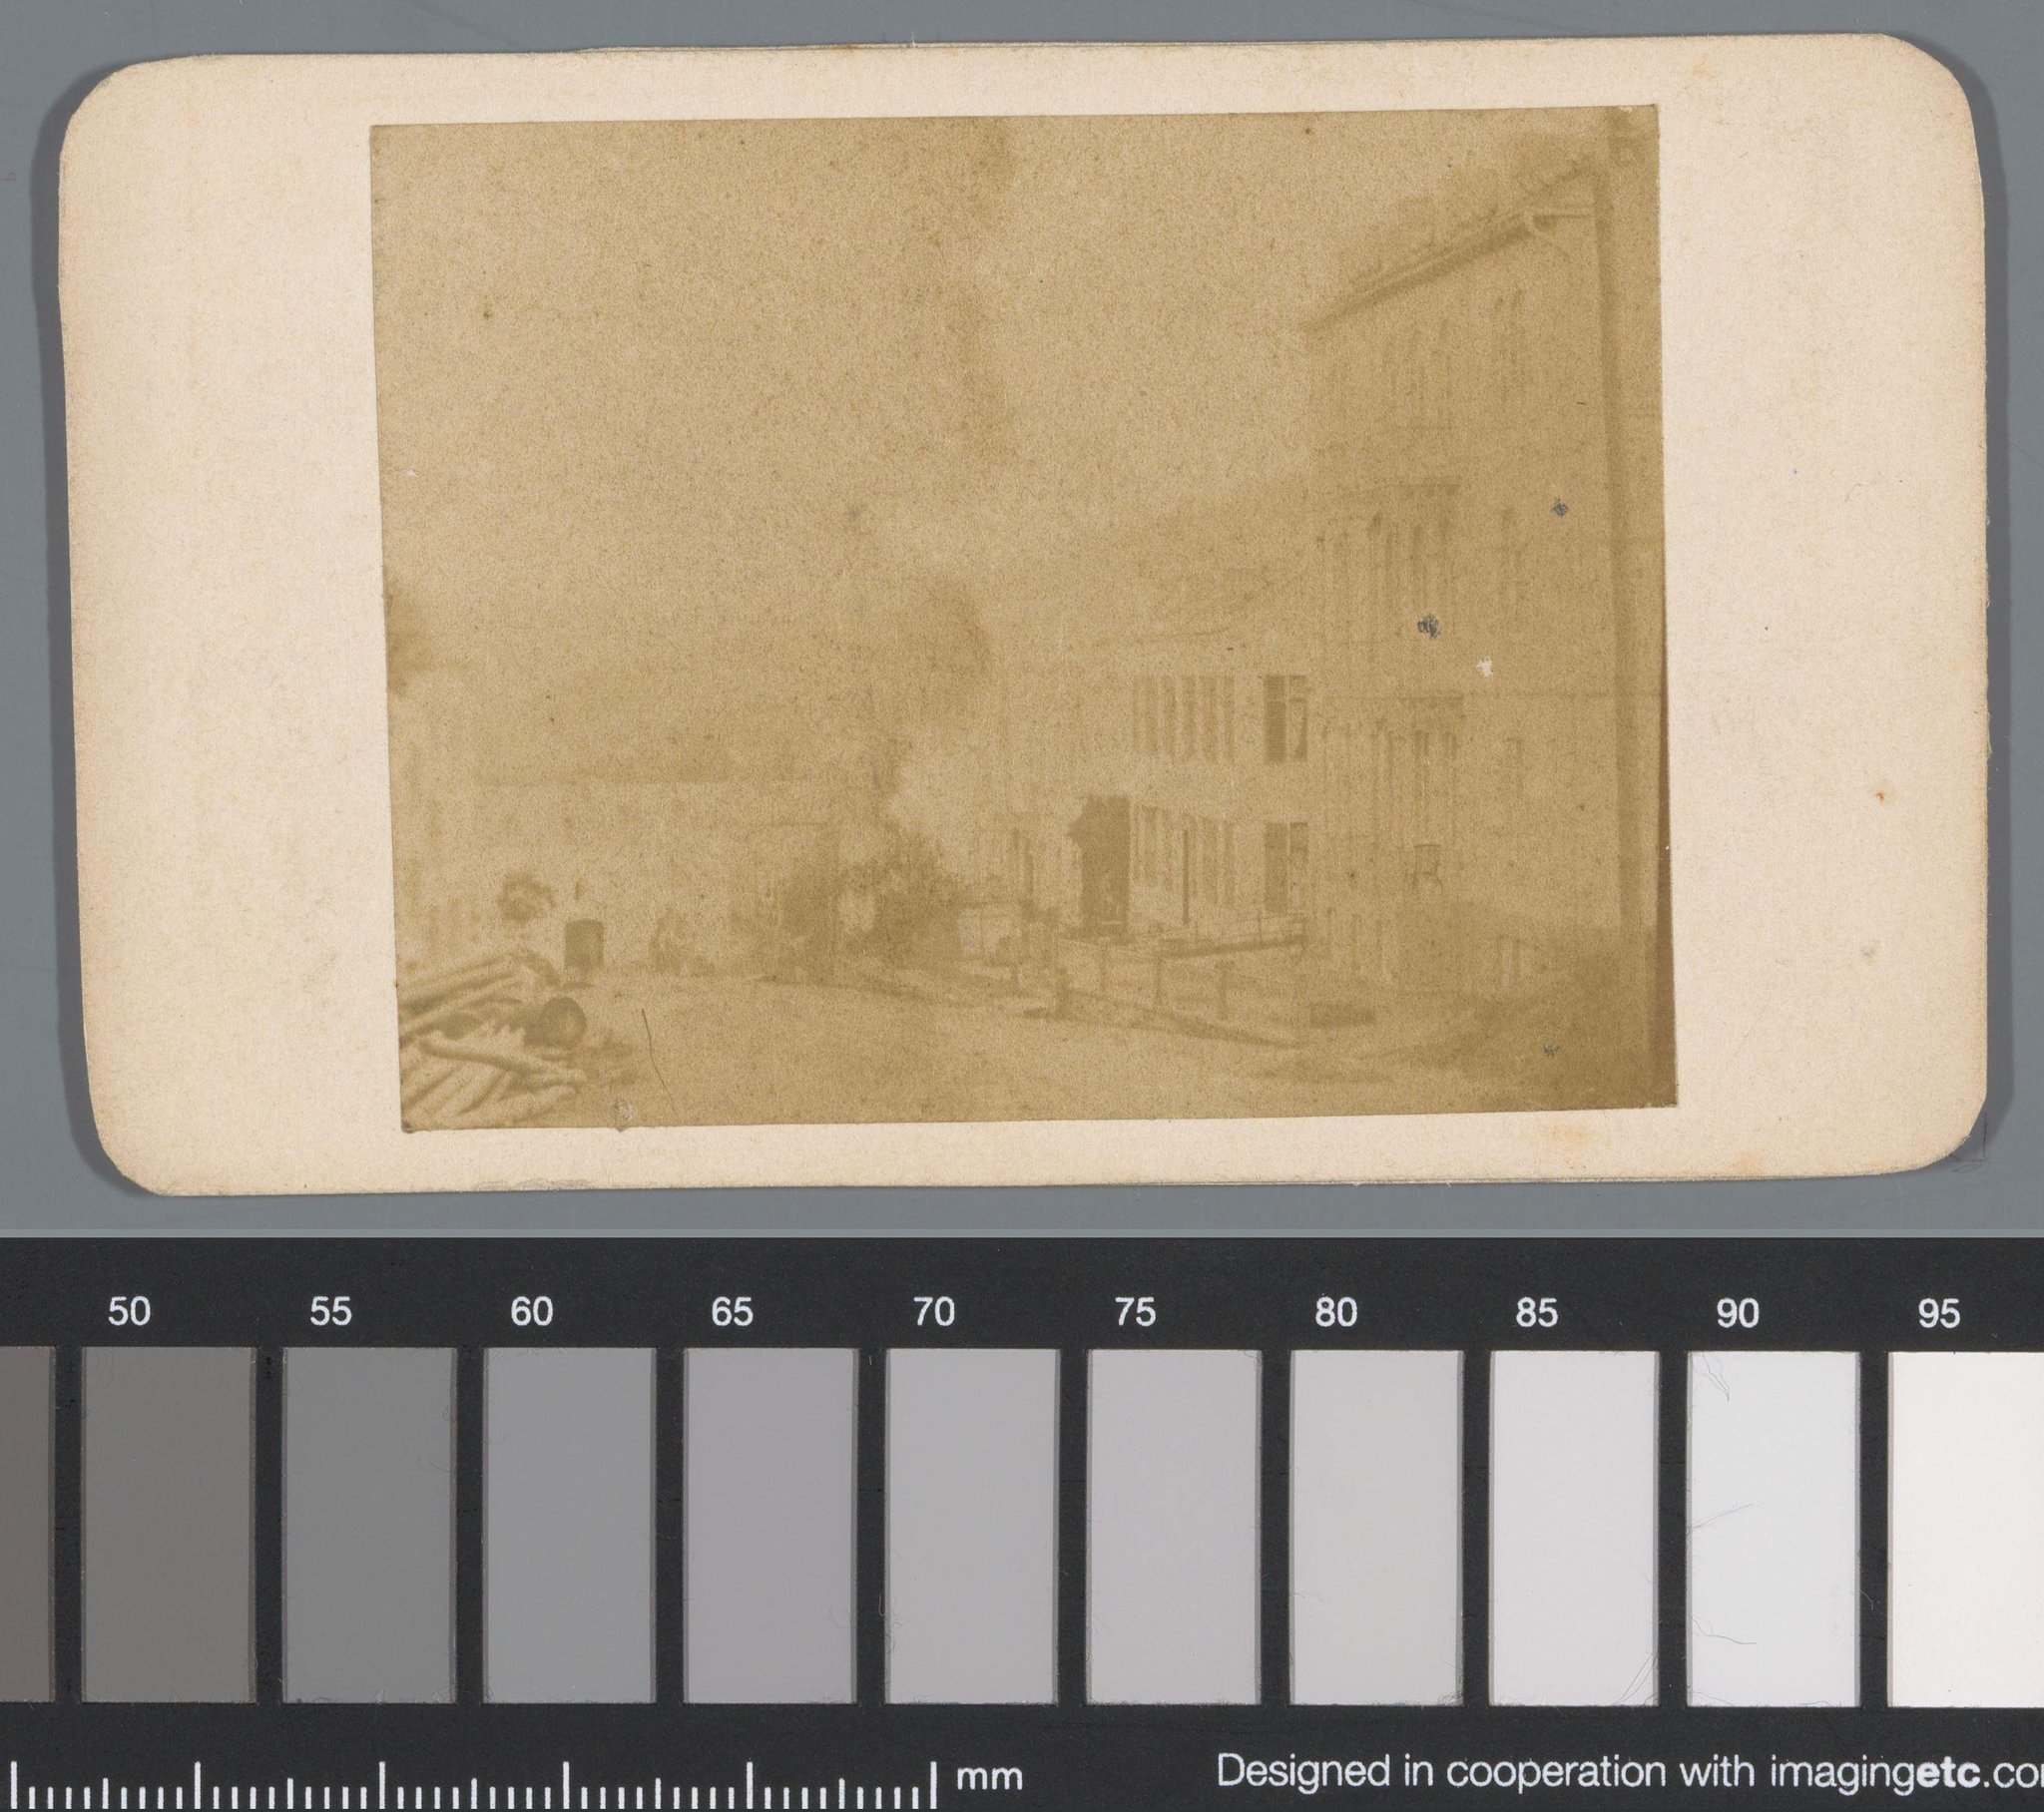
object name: carte de visite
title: Gebouw in Bad Schwalbach, Duitsland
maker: georg raidt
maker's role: fotograaf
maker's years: 1836-1892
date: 1855-1885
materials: cardboard, paper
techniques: albumen print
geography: bad schwalbach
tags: exterior ~ representation of a building